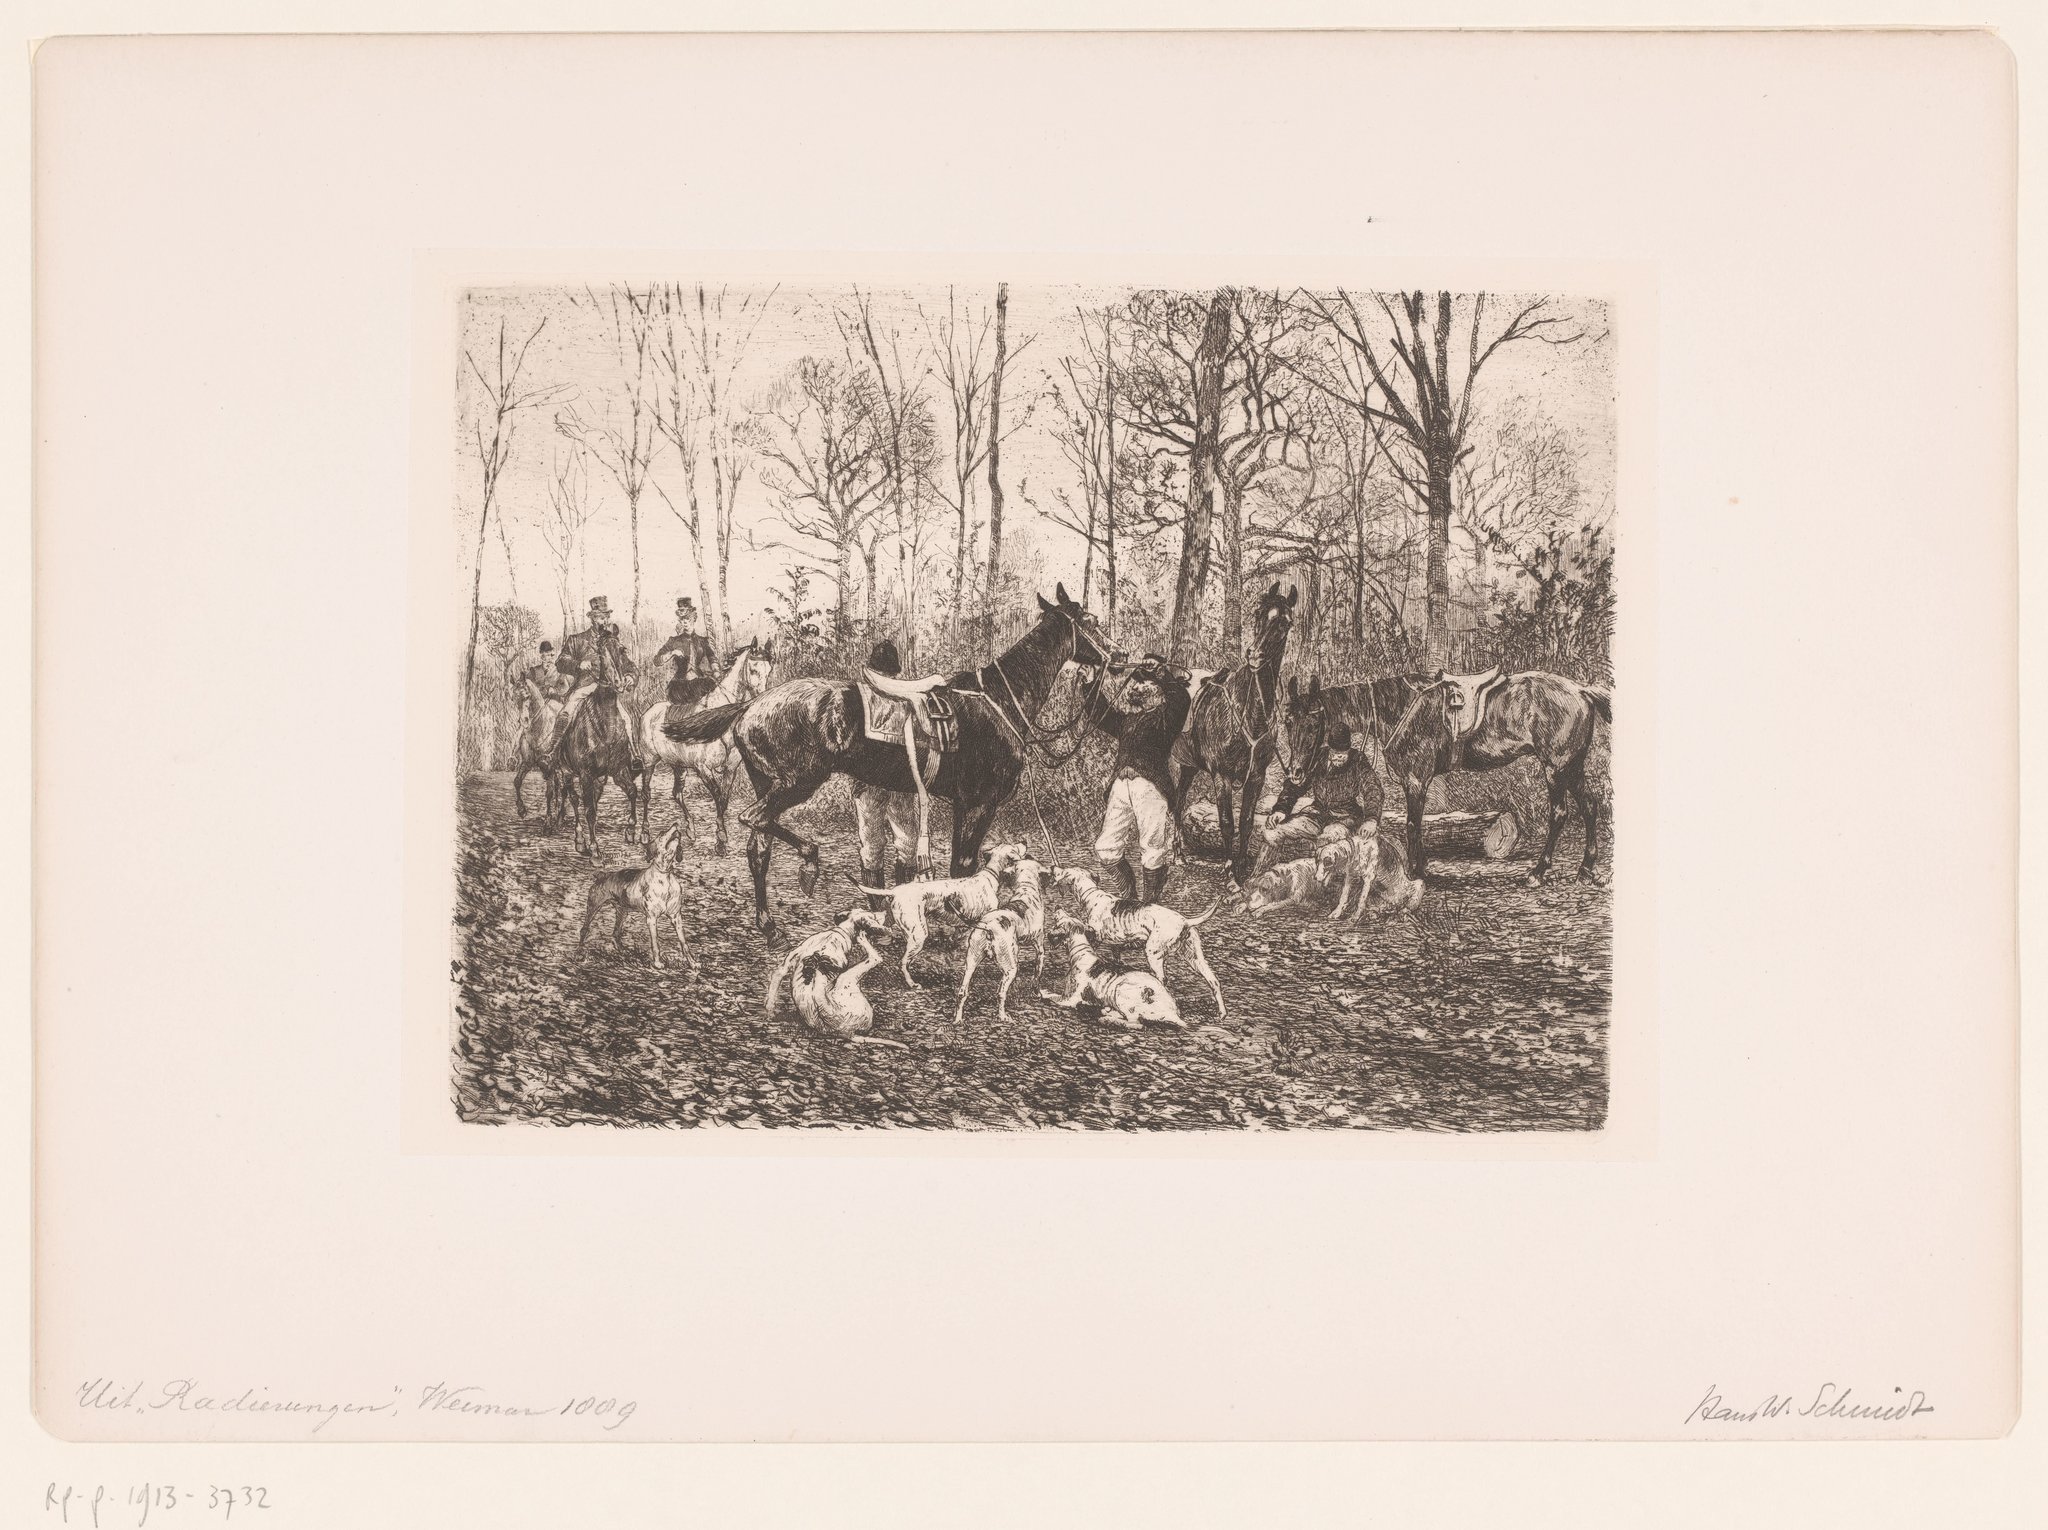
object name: print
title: Rendez-vous zur Parforce-Jagd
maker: hans w. schmidt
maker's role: print maker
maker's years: 1859-1950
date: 1889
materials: paper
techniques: etching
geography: weimar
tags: hunters resting during the hunt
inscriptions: : ‘Uit "Radierungen" Weimar 1889 Hans W. Schmidt’, collector's mark: Lugt 2228